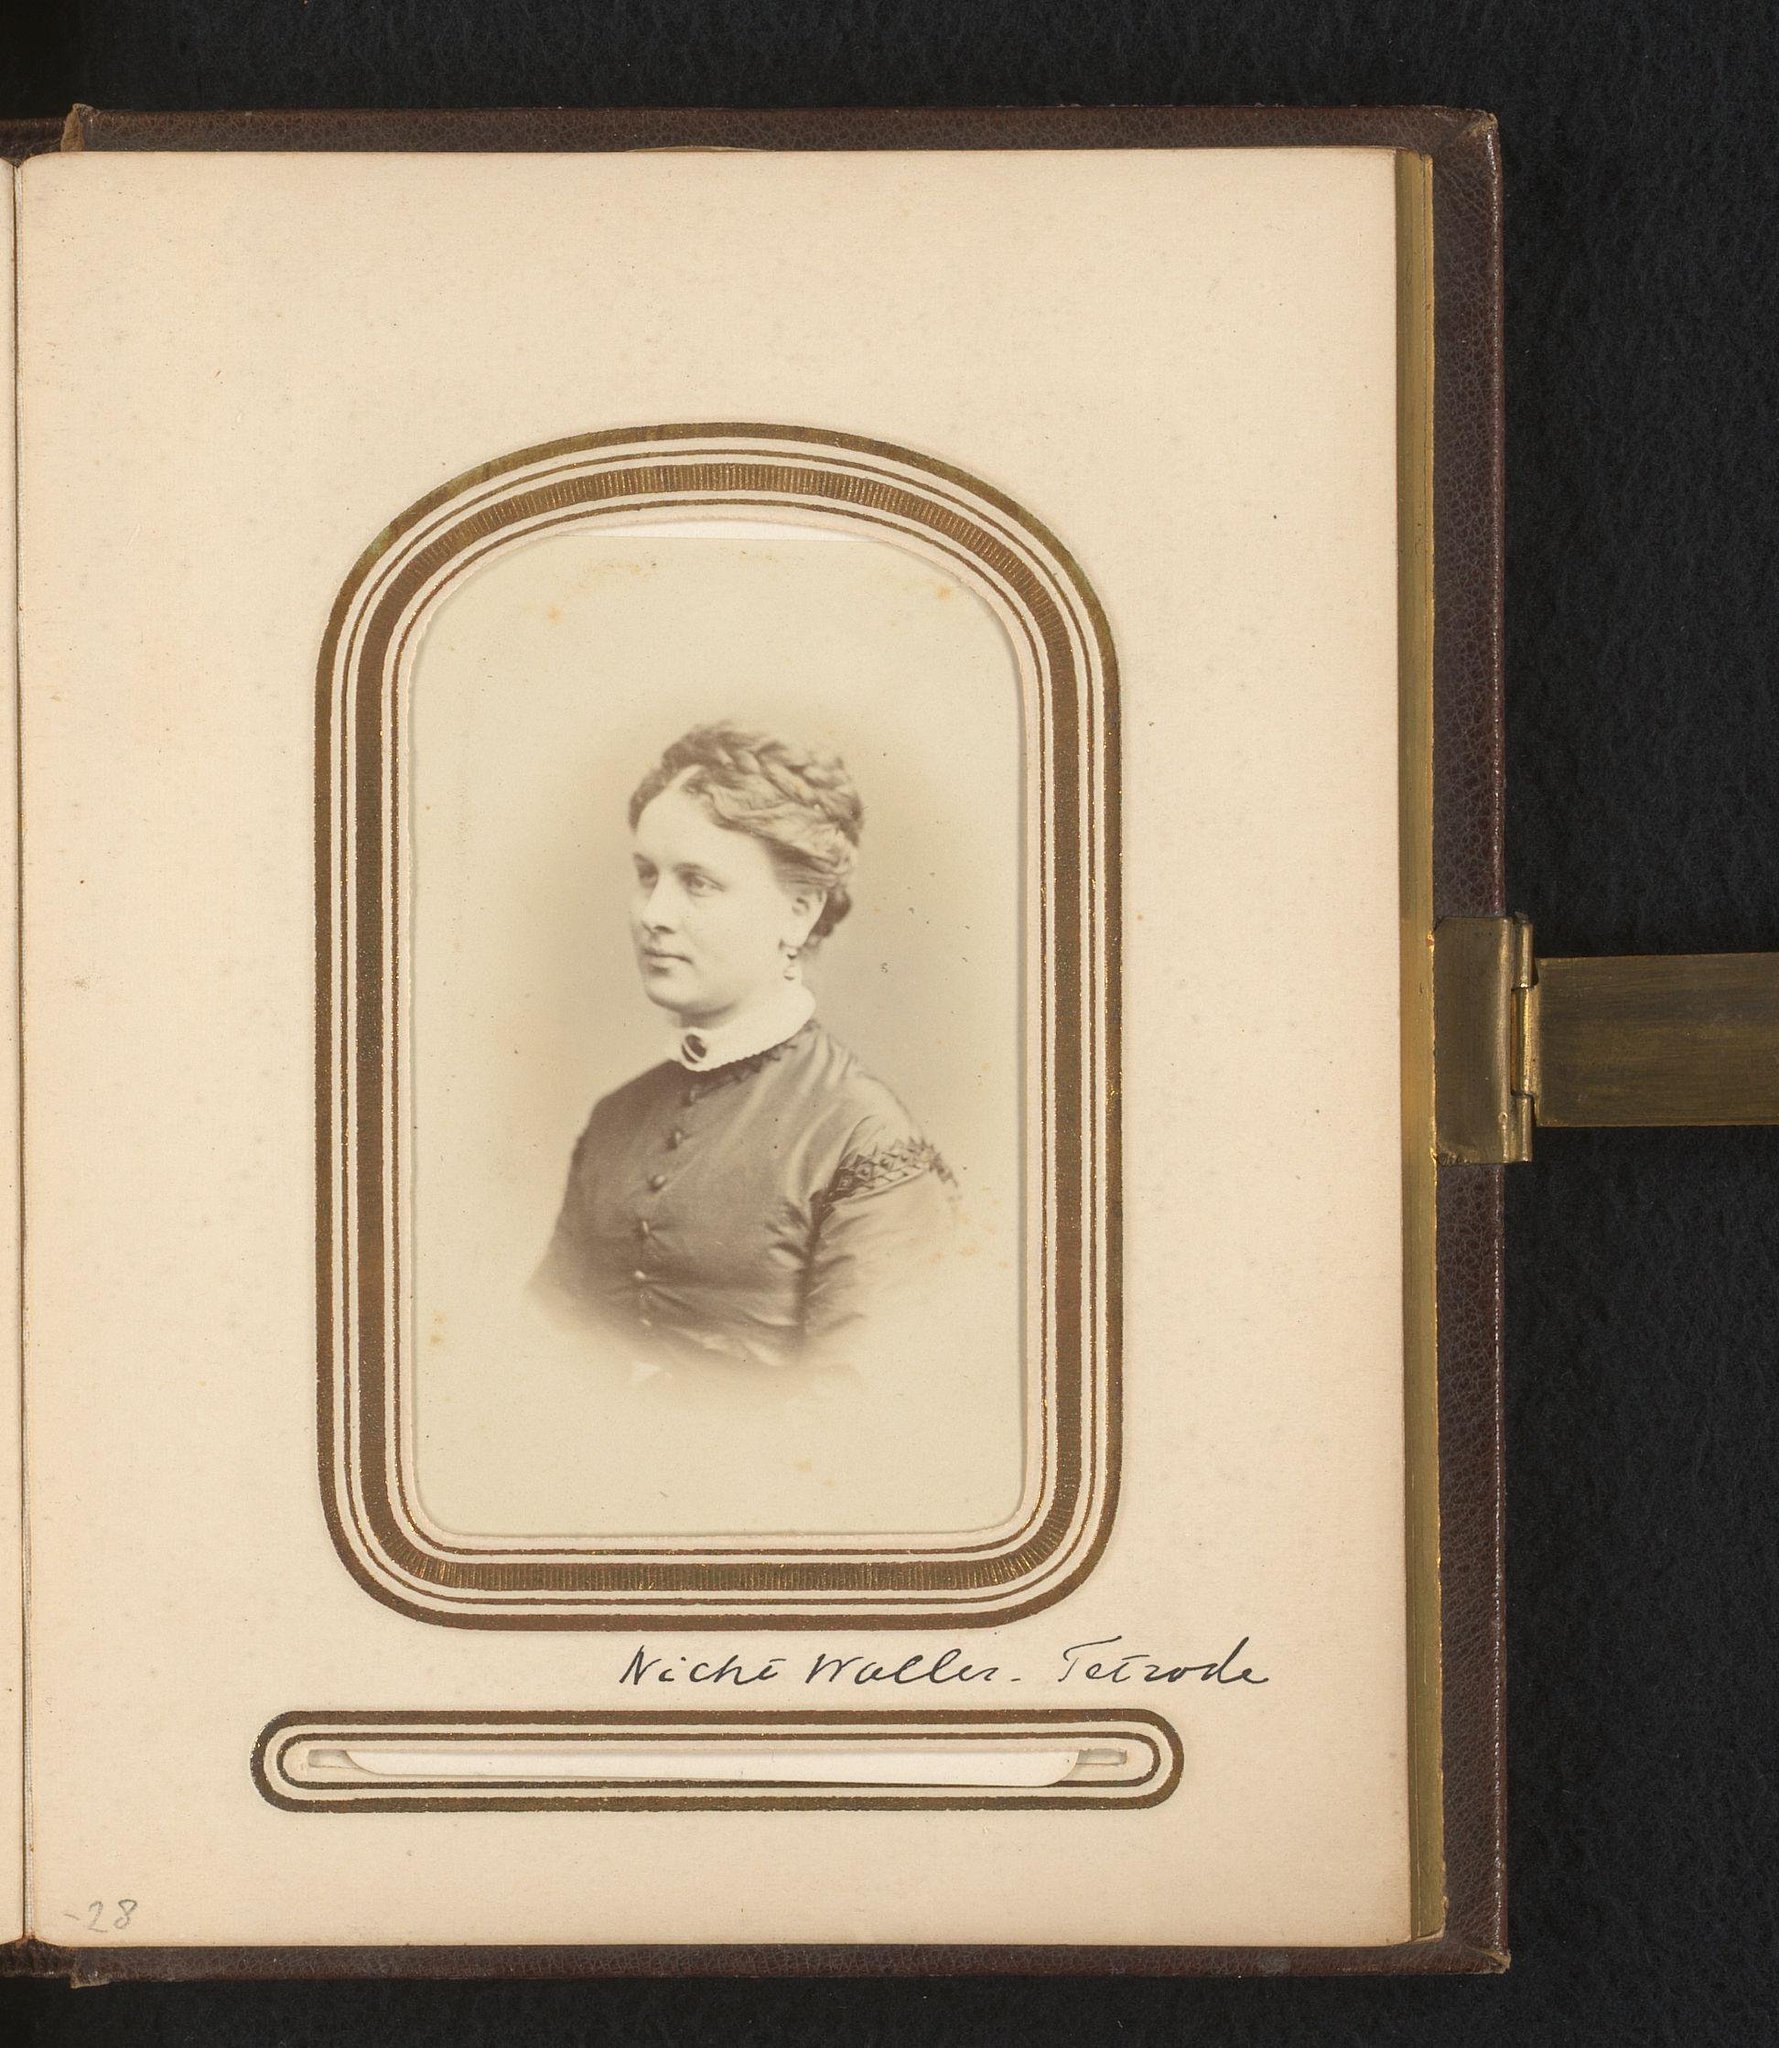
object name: carte de visite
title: Niche Waller-Tetrode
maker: albert greiner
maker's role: fotograaf, fotostudio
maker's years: 1833-1890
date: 1861-1874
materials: cardboard, paper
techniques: albumen print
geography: amsterdam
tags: amsterdam, historical persons - bb - woman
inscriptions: address: ‘NIEUWENDIJK. L. 87/ AMSTERDAM’